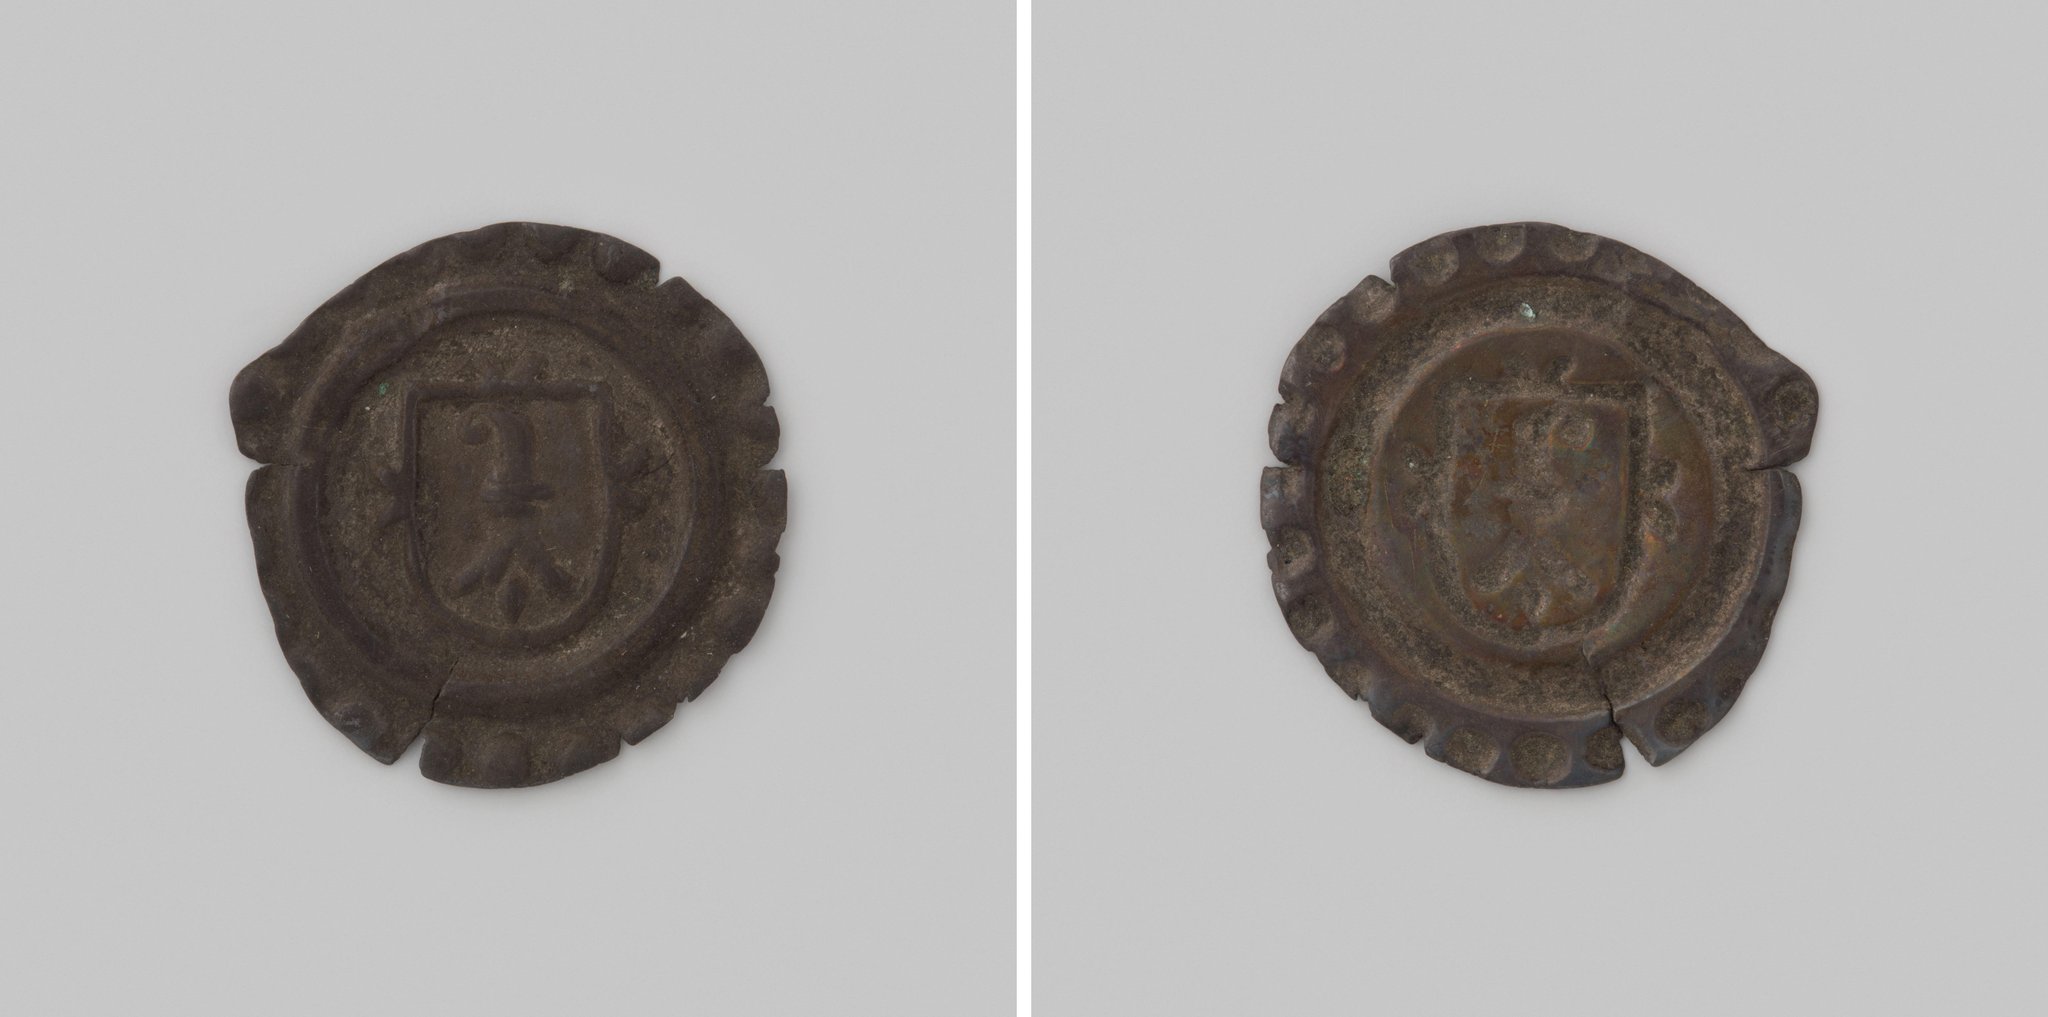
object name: coin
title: Bracteaat of holmunt uit de stad Bazel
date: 1400-1499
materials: silver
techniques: striking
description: Zilveren, eenzijdig geslagen munt. Voorzijde: versierd wapenschild. Keerzijde: hol.